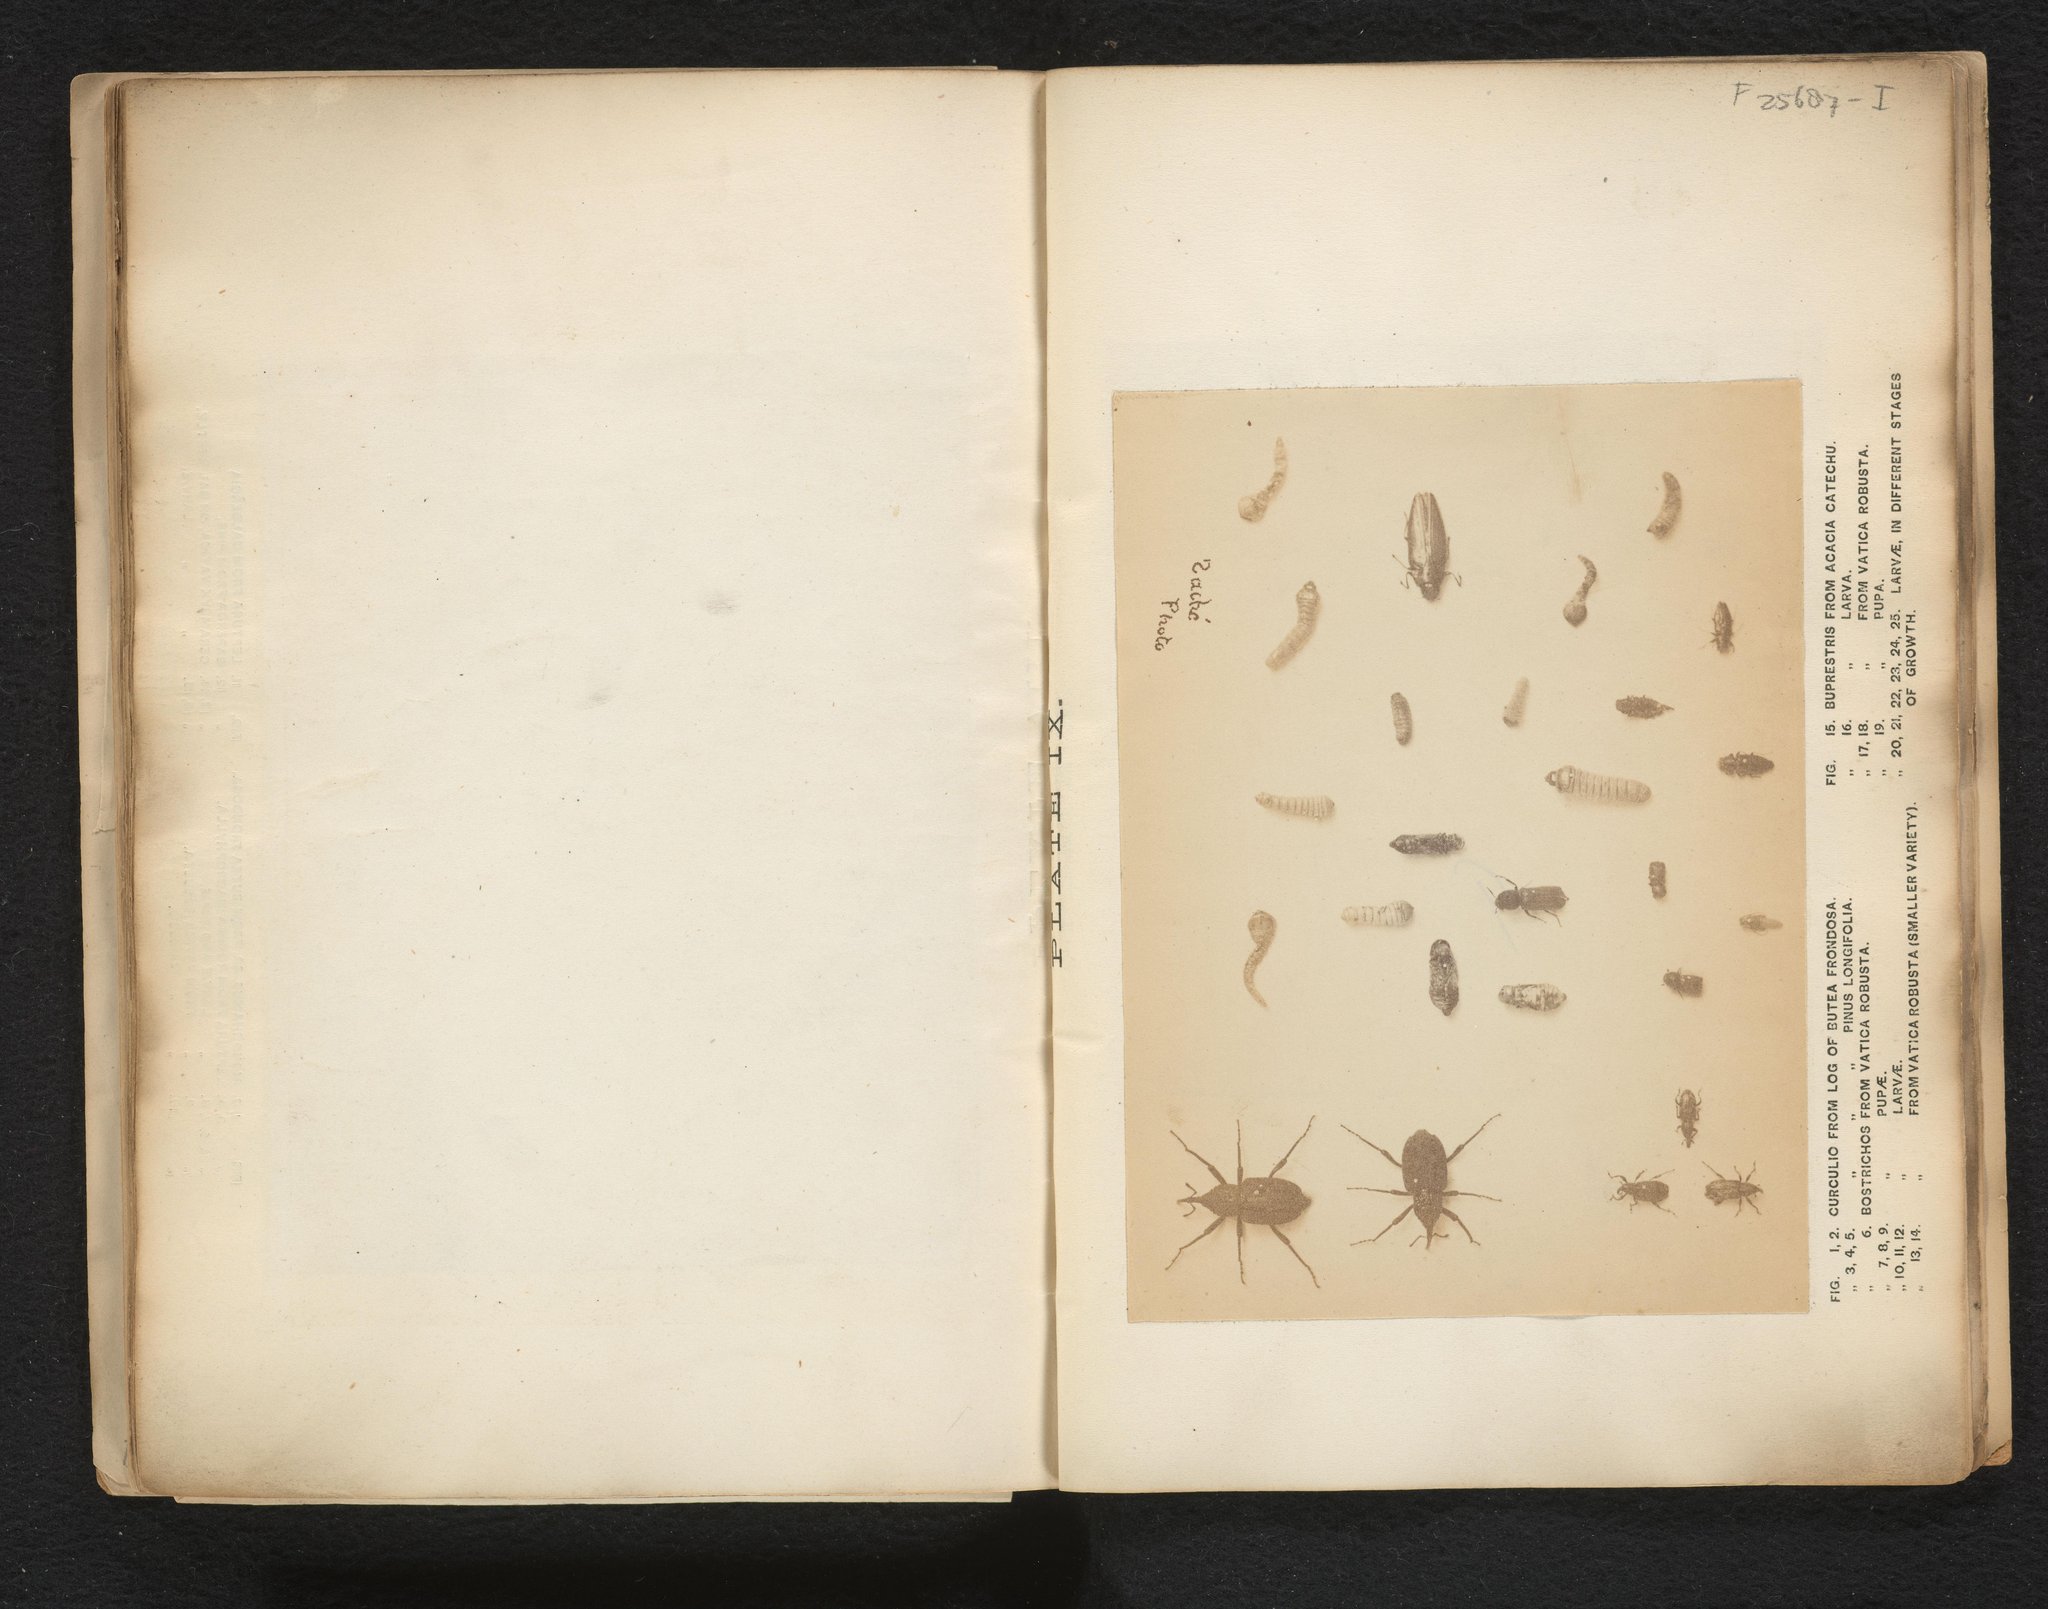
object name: photograph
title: Overview of different types of beetles and larvae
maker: john edward saché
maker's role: fotograaf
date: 1863-1868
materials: paper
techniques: albumen print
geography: india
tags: insects: beetle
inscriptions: inscription: ‘PLATE IX.’, inscription: ‘FIG. 1,2. CURCULIO FROM LOG OF BUTEA FRONDOSA. ... 25. LARVAE, IN DIFFERENT STAGES OF GROWTH.’, inscription: ‘Saché Photo’